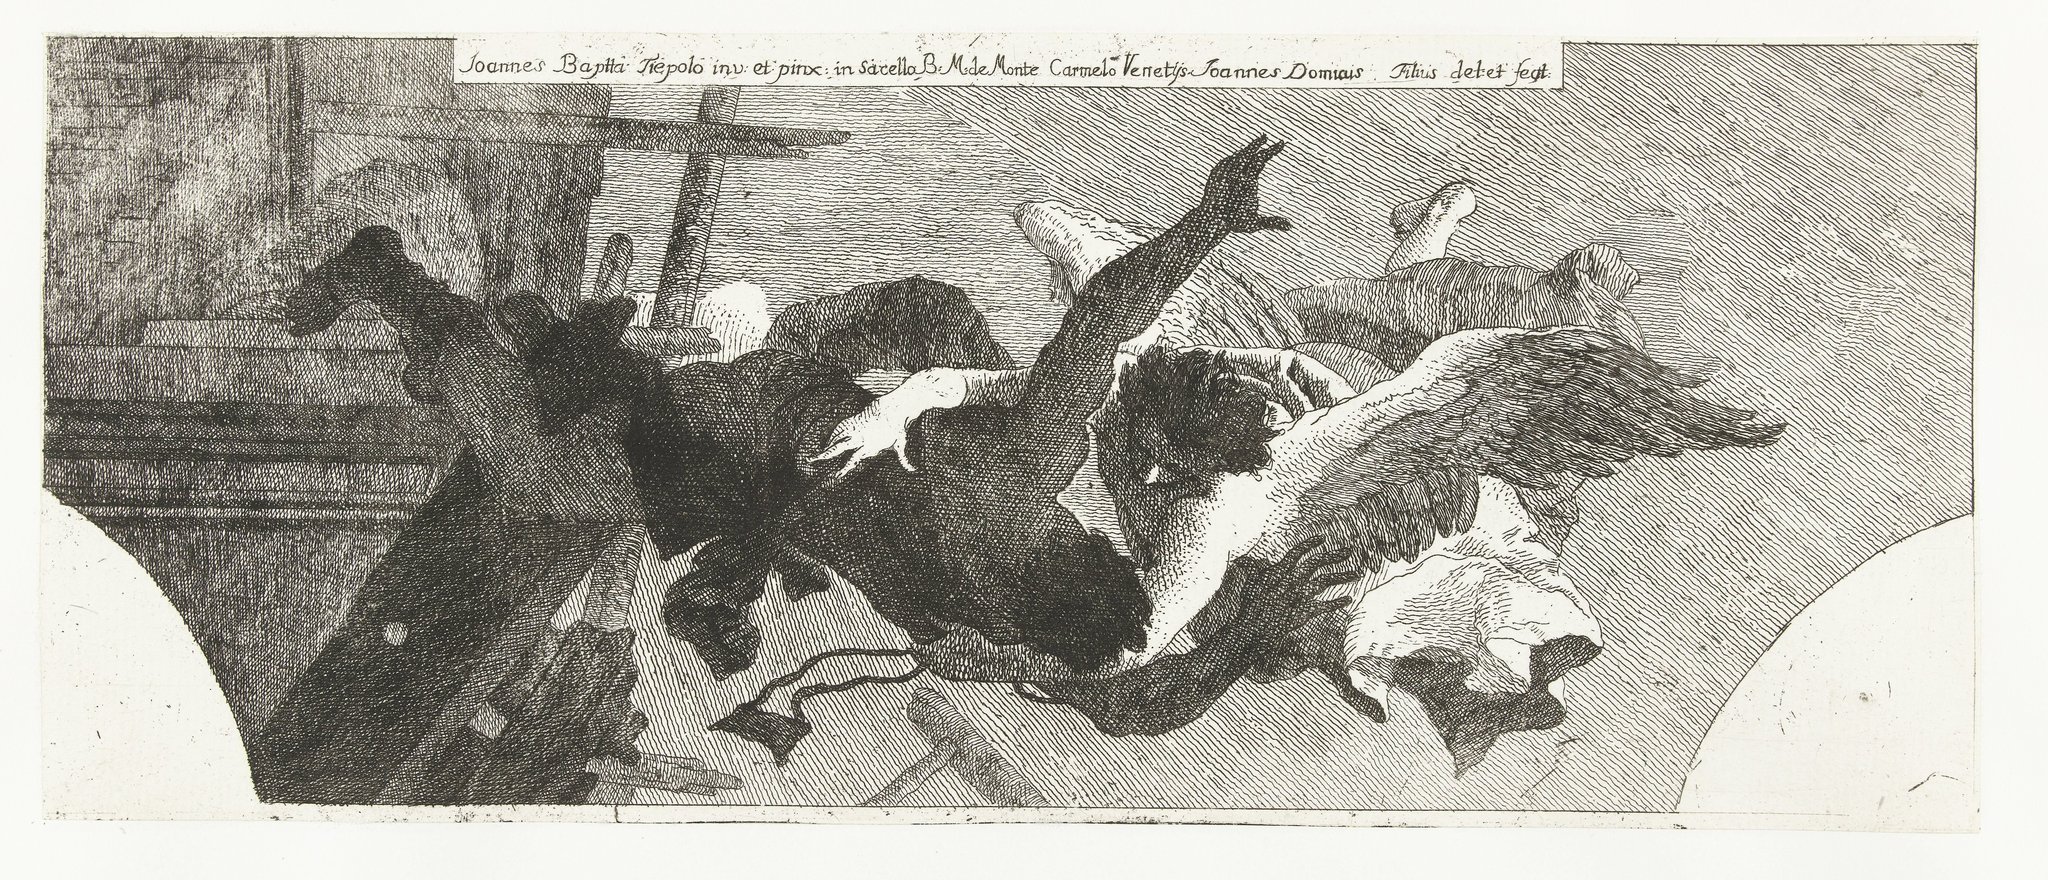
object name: print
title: Vallende man wordt opgevangen door engel met scapulier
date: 1742-1746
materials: paper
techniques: etching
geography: venice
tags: angels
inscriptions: collector's mark: Lugt 2228, collector's mark: Lugt 2760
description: Het opschrift boven de figuren verwijst naar de inspiratiebron voor deze voorstelling: een plafondschildering in de Scuola dei Carmini te Venetië.